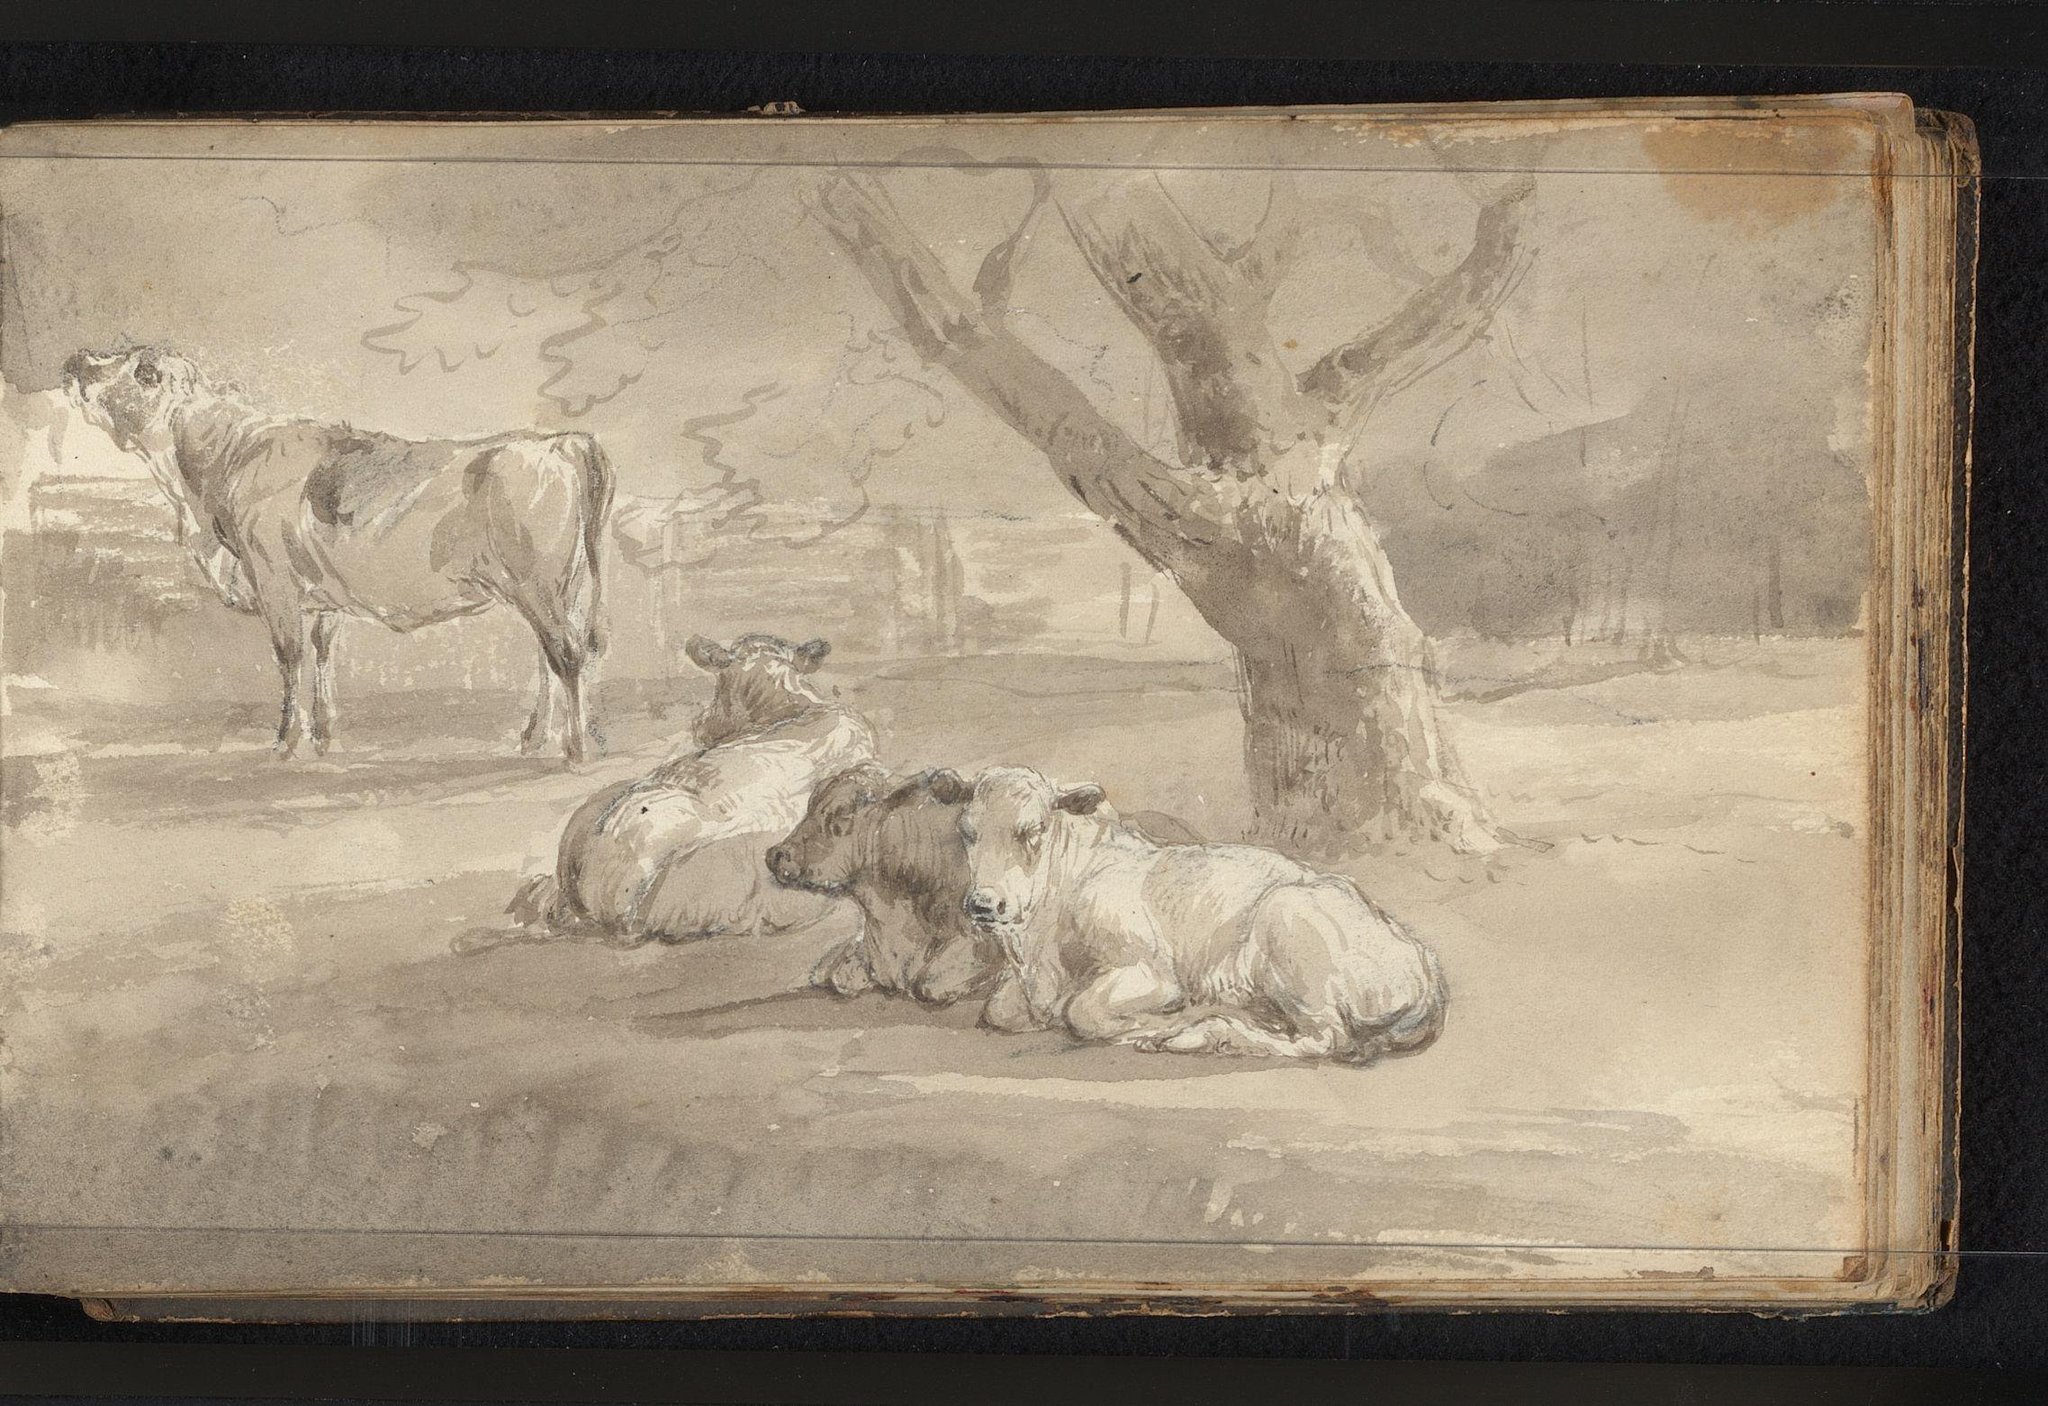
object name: sketchbook leaf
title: Runderen in een weiland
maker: jan bedijs tom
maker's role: draughtsman, painter, print maker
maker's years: 1813-1894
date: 1828-1894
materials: paper, pencil, watercolor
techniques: brush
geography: the hague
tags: trees, landscapes, meadow, pasture, artist (in general) making preliminary designs, sketching, bovine cattle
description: Pagina 40 verso uit een schetsboek met 54 bladen.